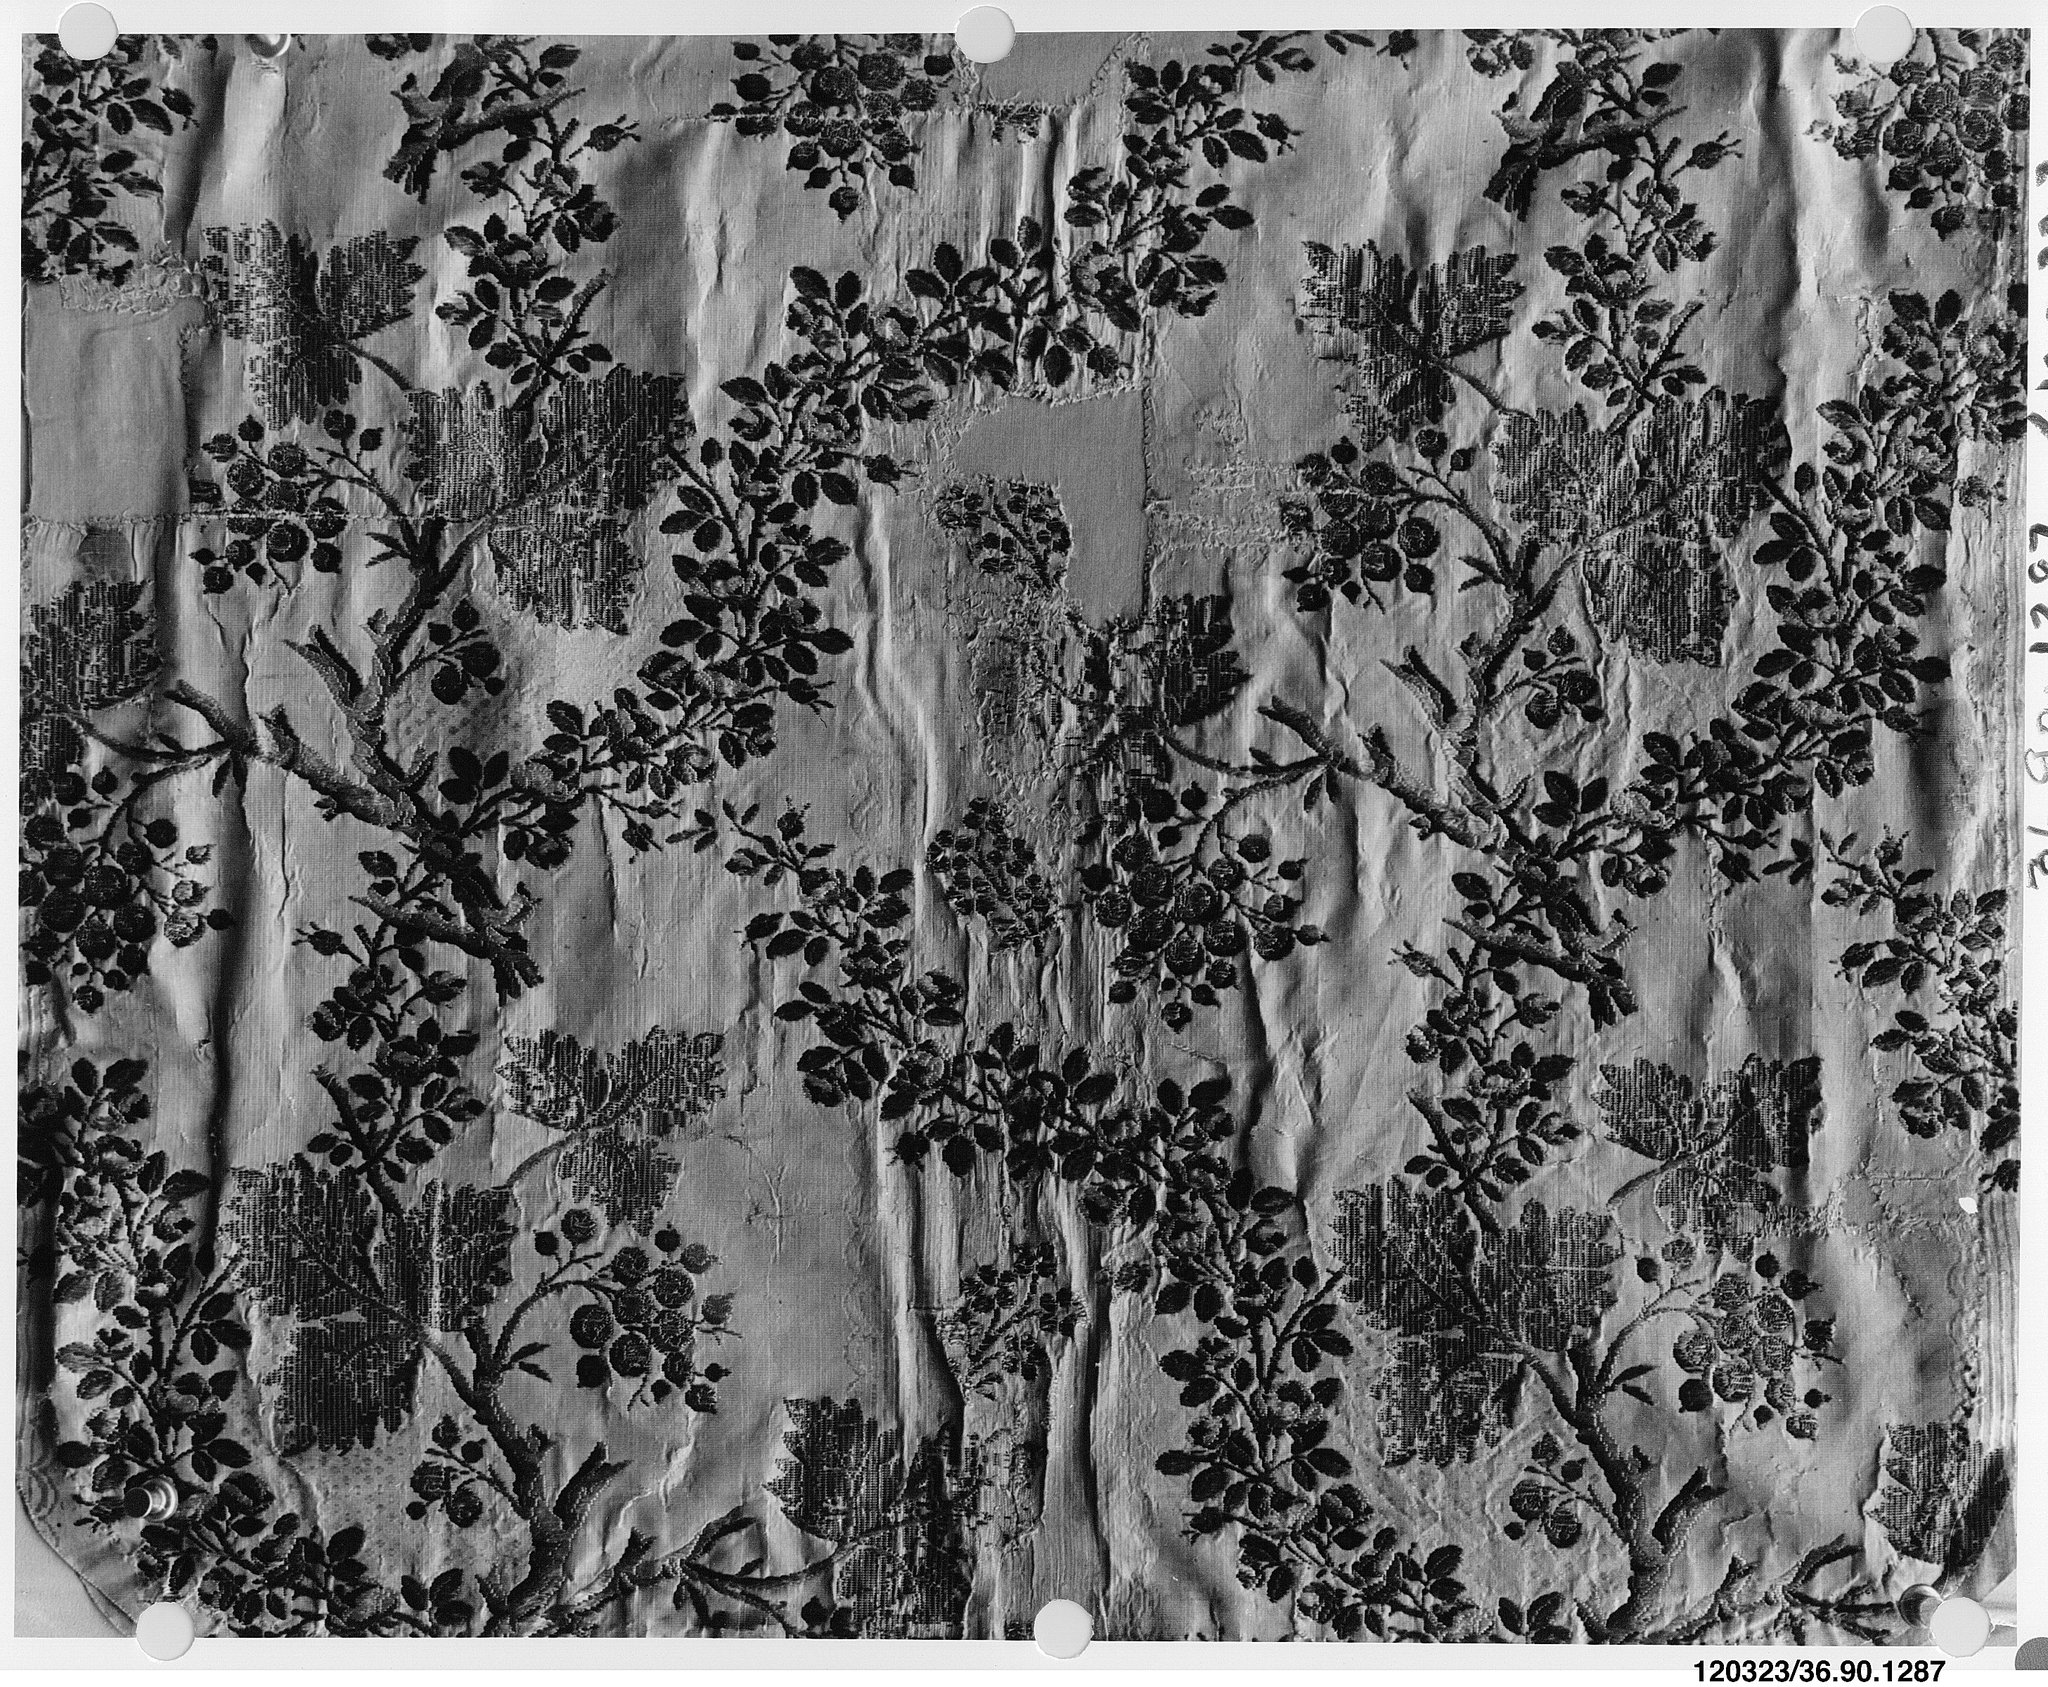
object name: piece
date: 1750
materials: metal thread, silk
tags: flowers,leaves